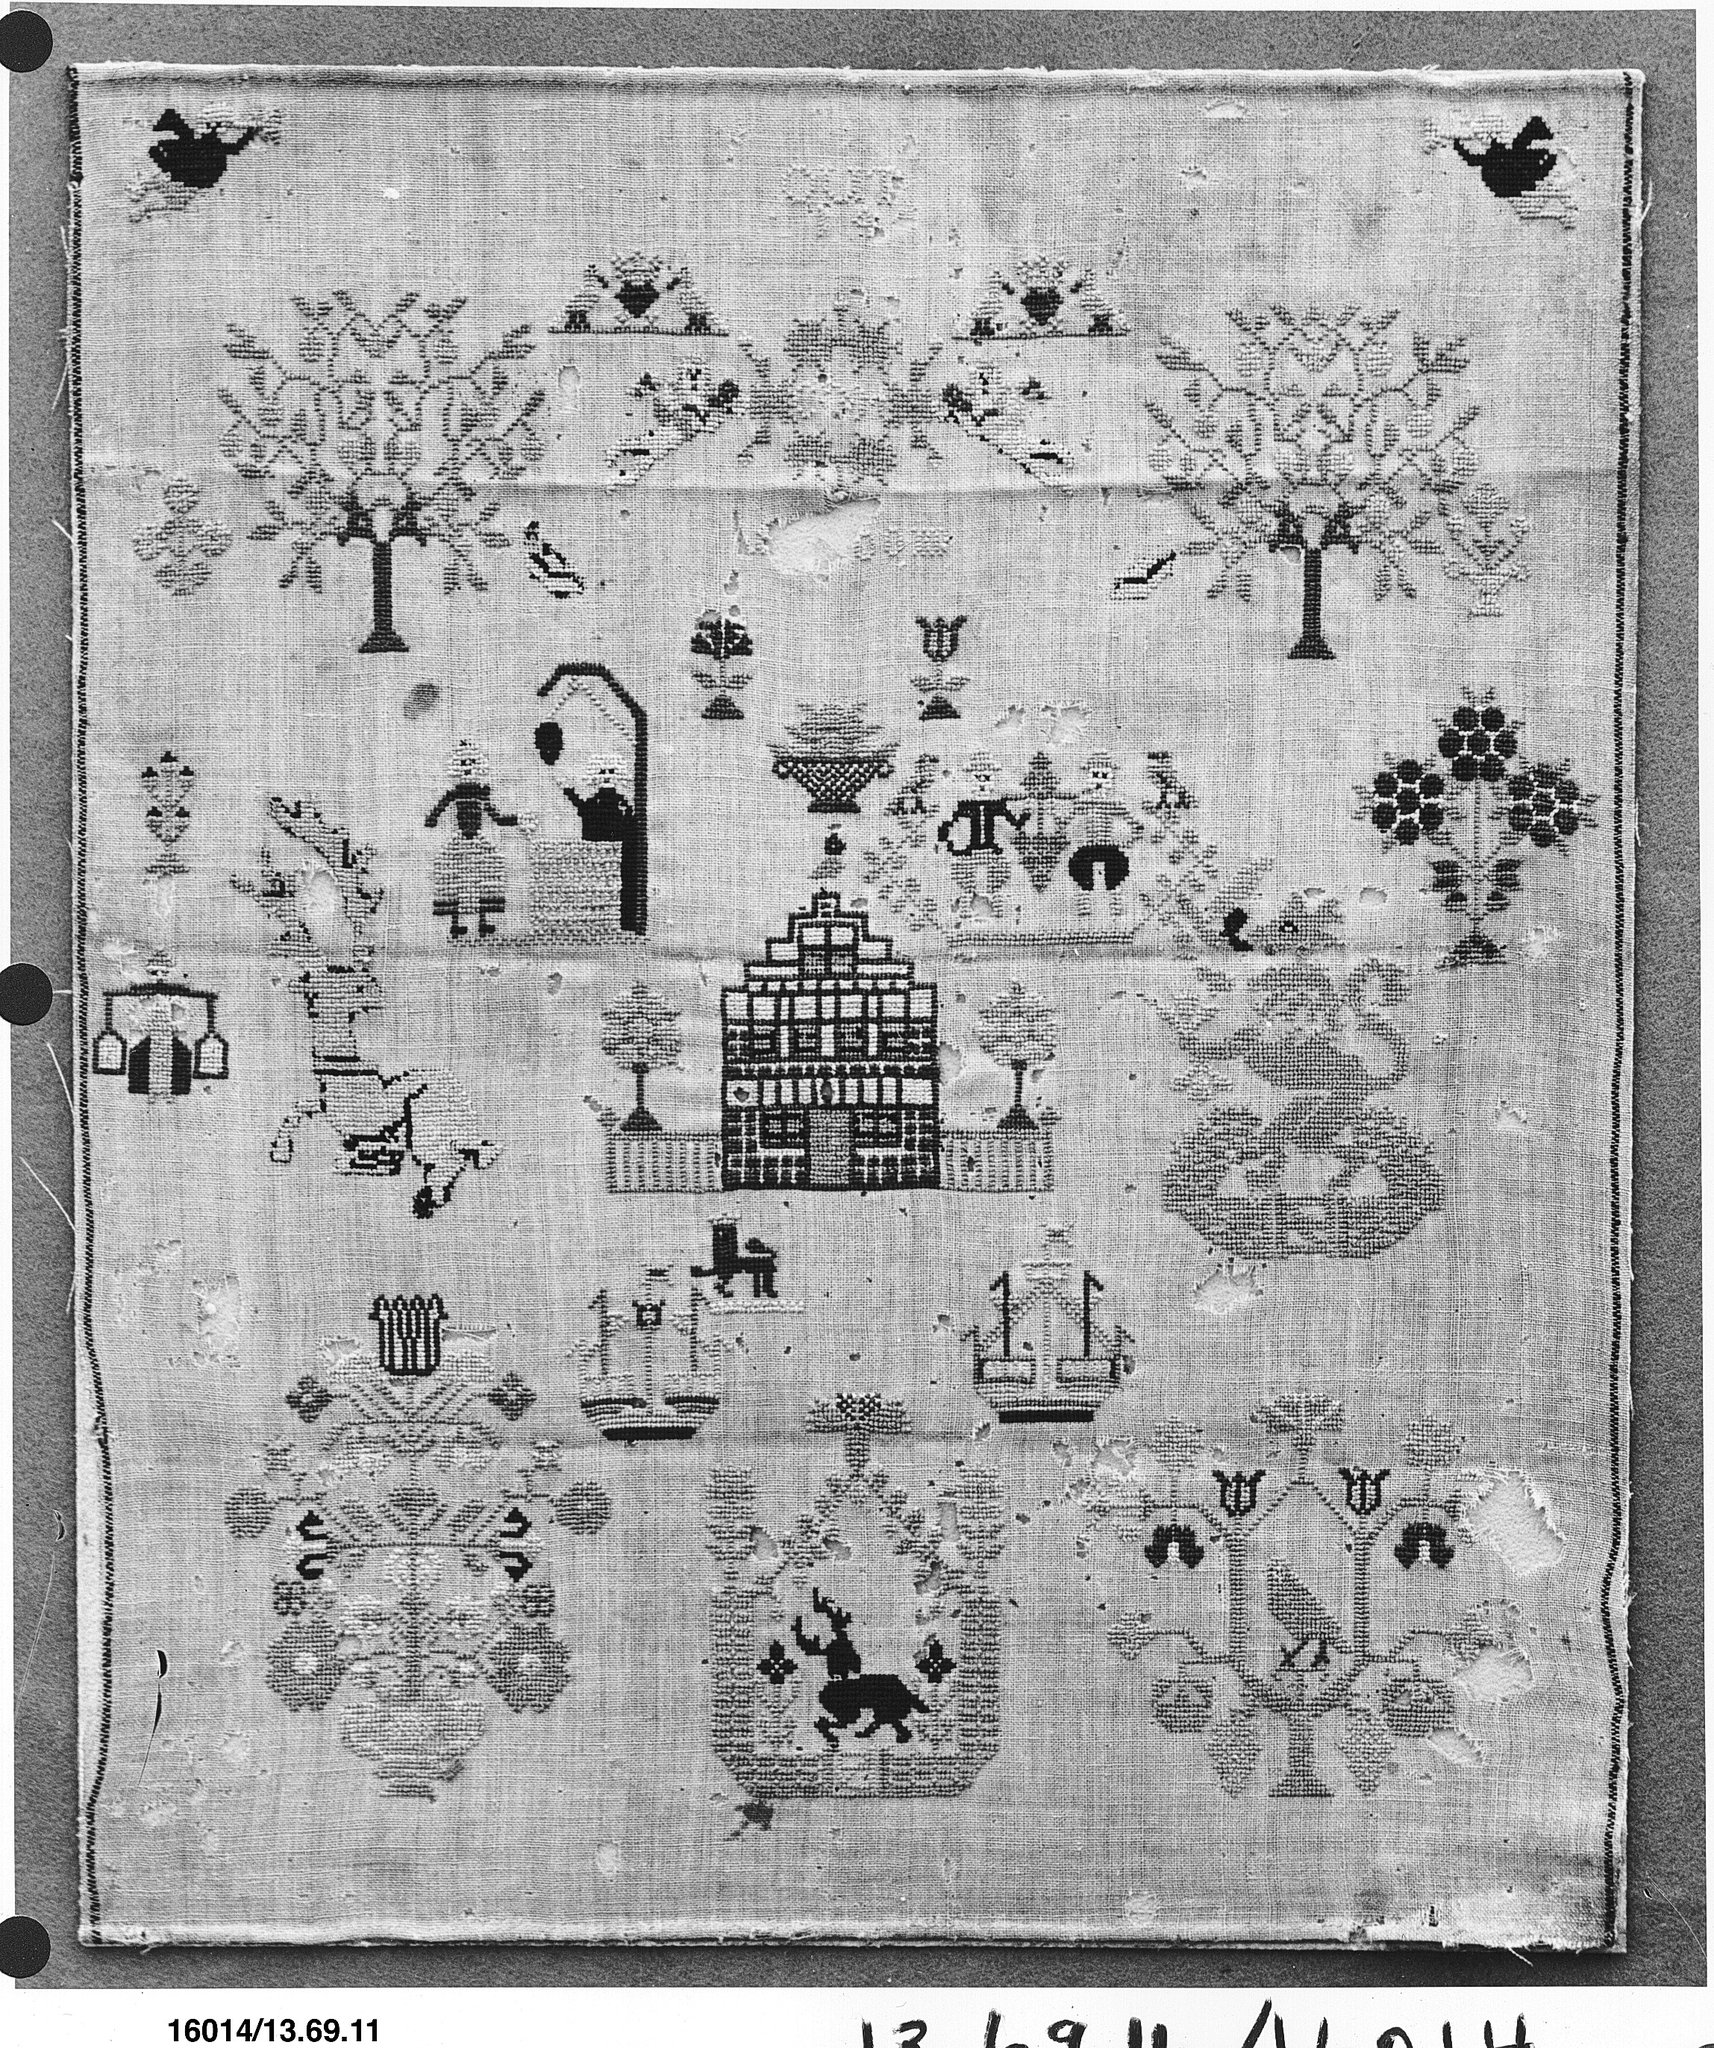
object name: sampler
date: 1801-1900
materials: canvas, silk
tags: human figures,animals,houses,trees